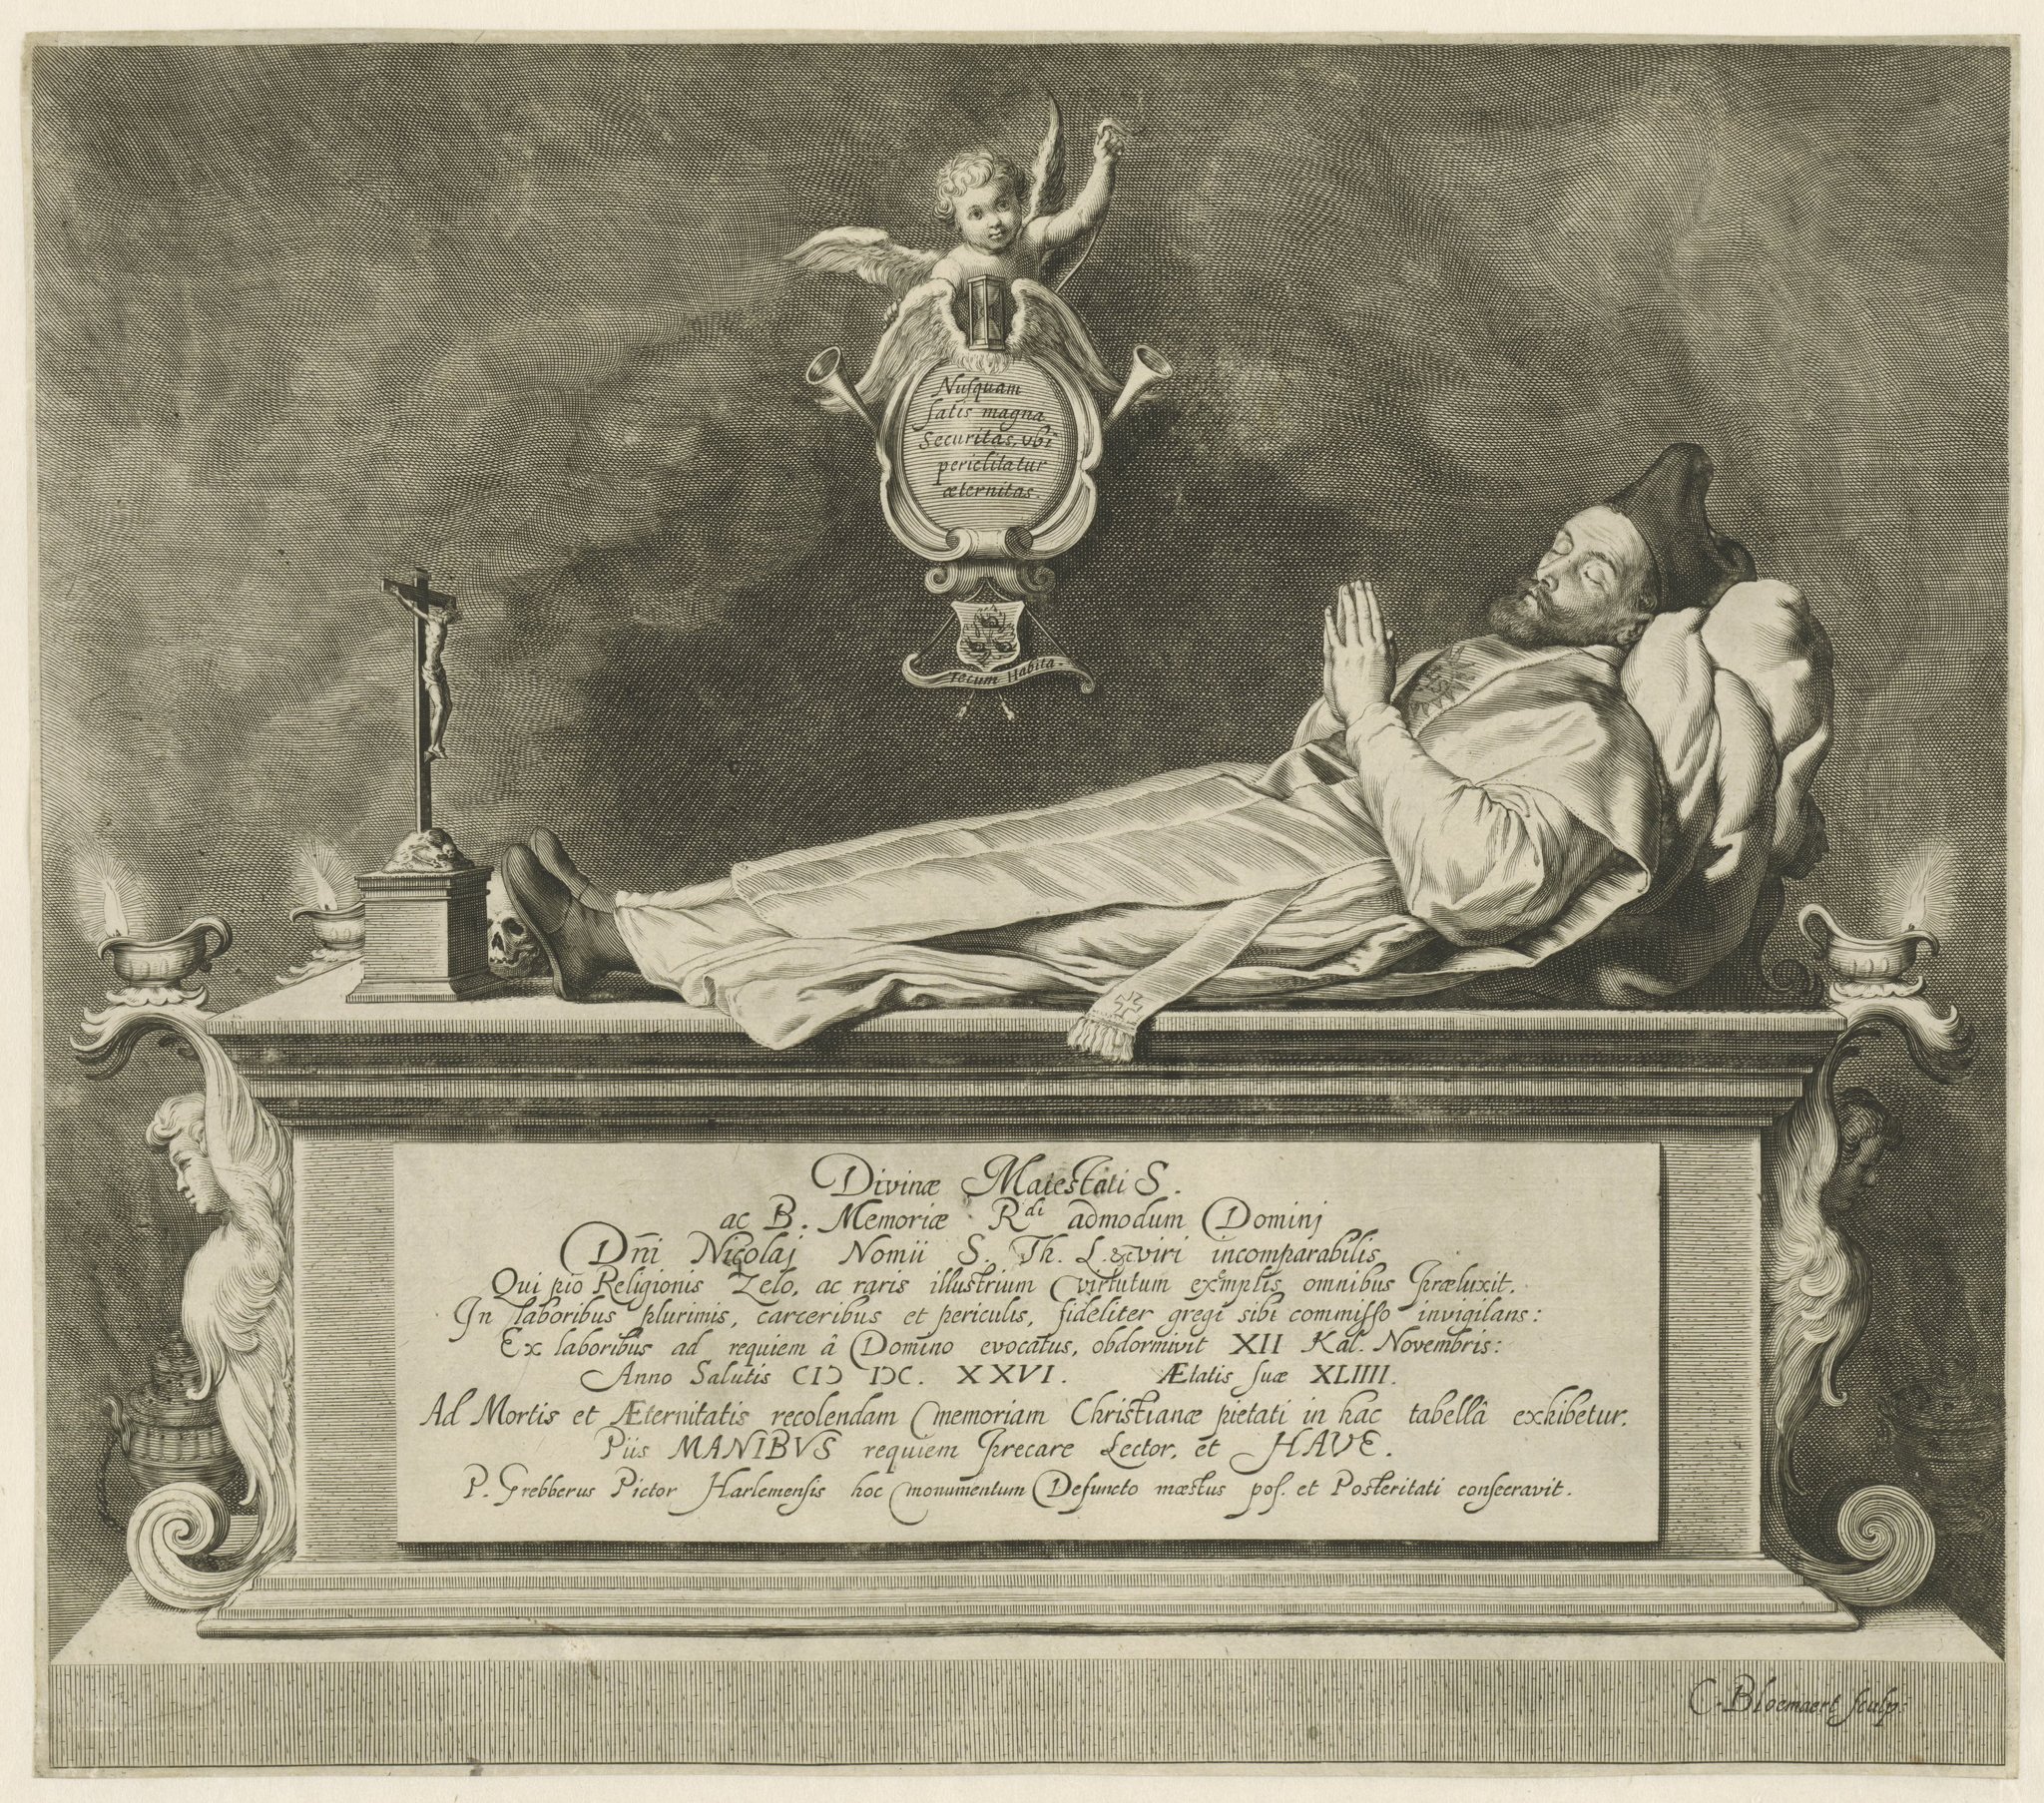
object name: print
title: Graftombe van Nicolaes Nomius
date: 1626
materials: paper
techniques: engraving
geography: haarlem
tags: effigy, 'gisant' (portrait-figure on closed coffin or in 'castrum doloris'), transi, grave, tomb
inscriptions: collector's mark: Lugt 240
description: Graftombe van Nicolaes Nomius, met een beeld van de opgebaarde op de tombe. Aan zijn voeten staat een crucifix en een schedel. Op de tombe zijn naam en titels.